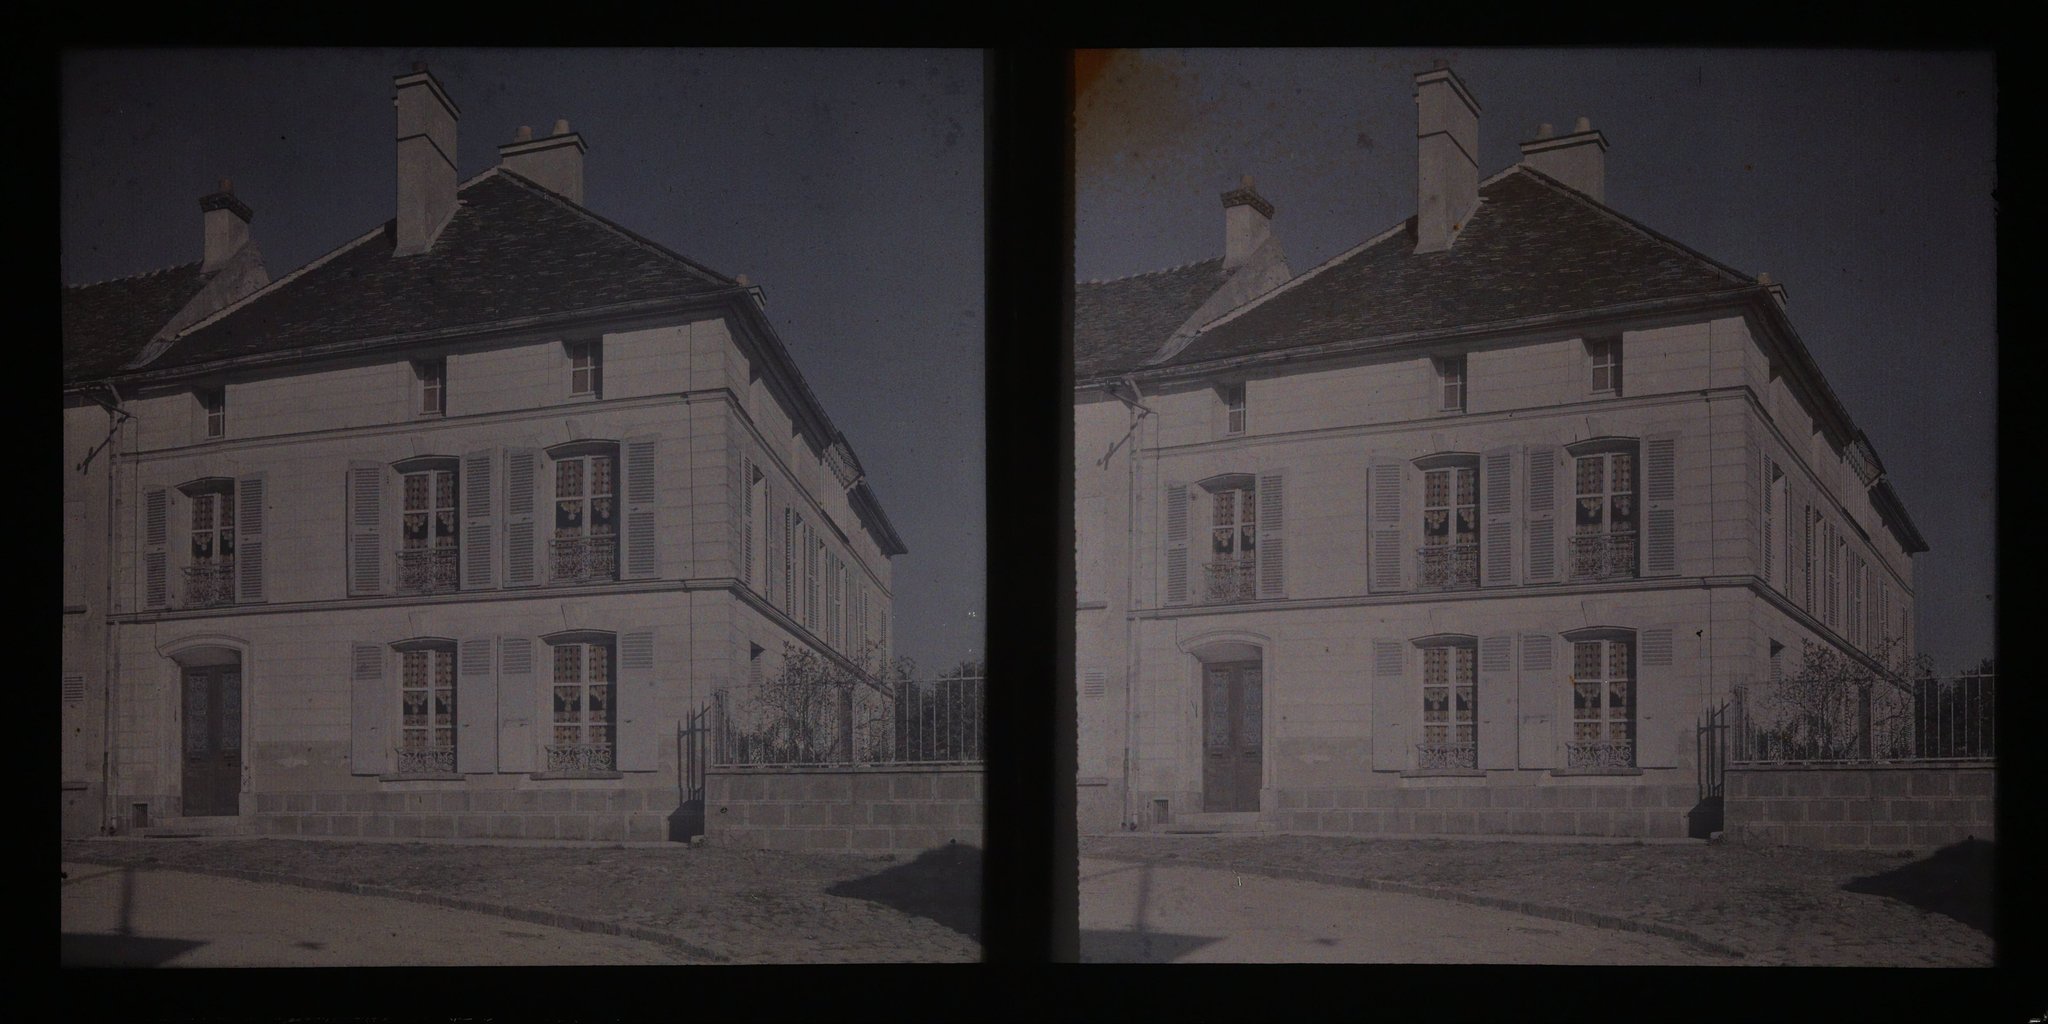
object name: stereograph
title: Huis gelegen in een bocht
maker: Anonymous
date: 1910-1940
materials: glass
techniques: autochrome process